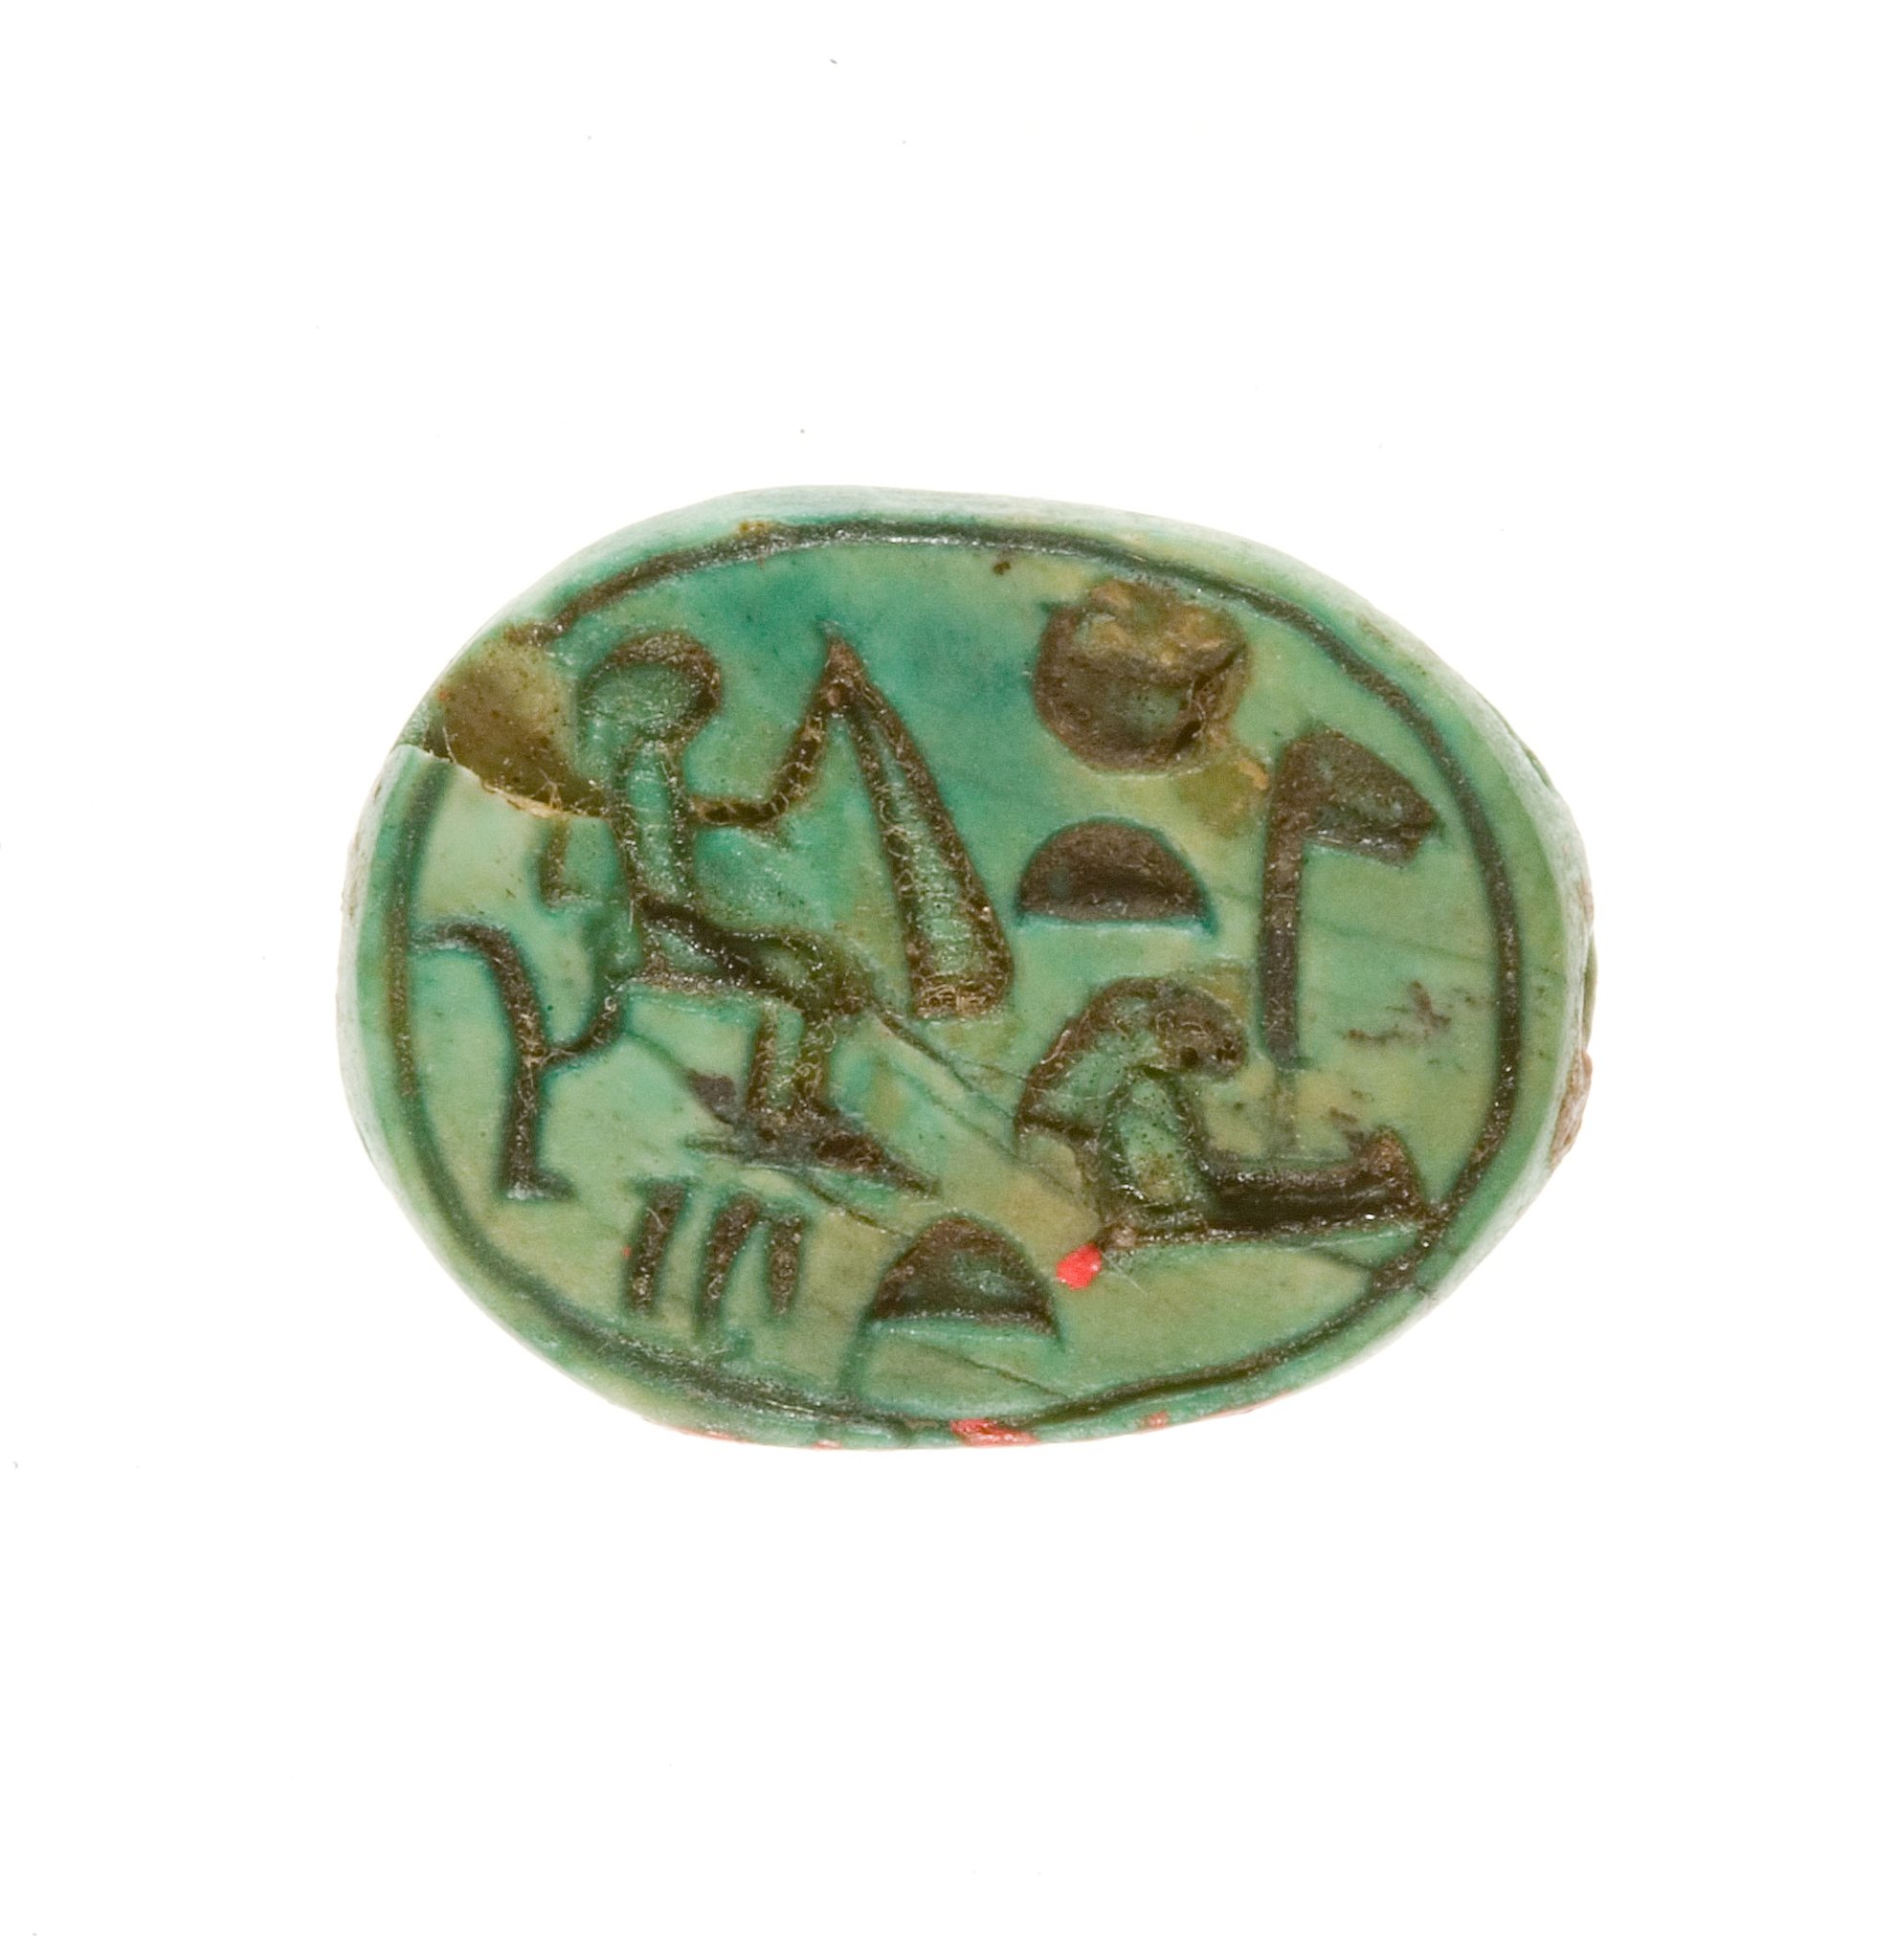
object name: scarab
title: Scarab Inscribed for the God's Wife Hatshepsut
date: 1479-1458 BCE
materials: stone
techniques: glazing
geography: egypt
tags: hieroglyphs,scarabs